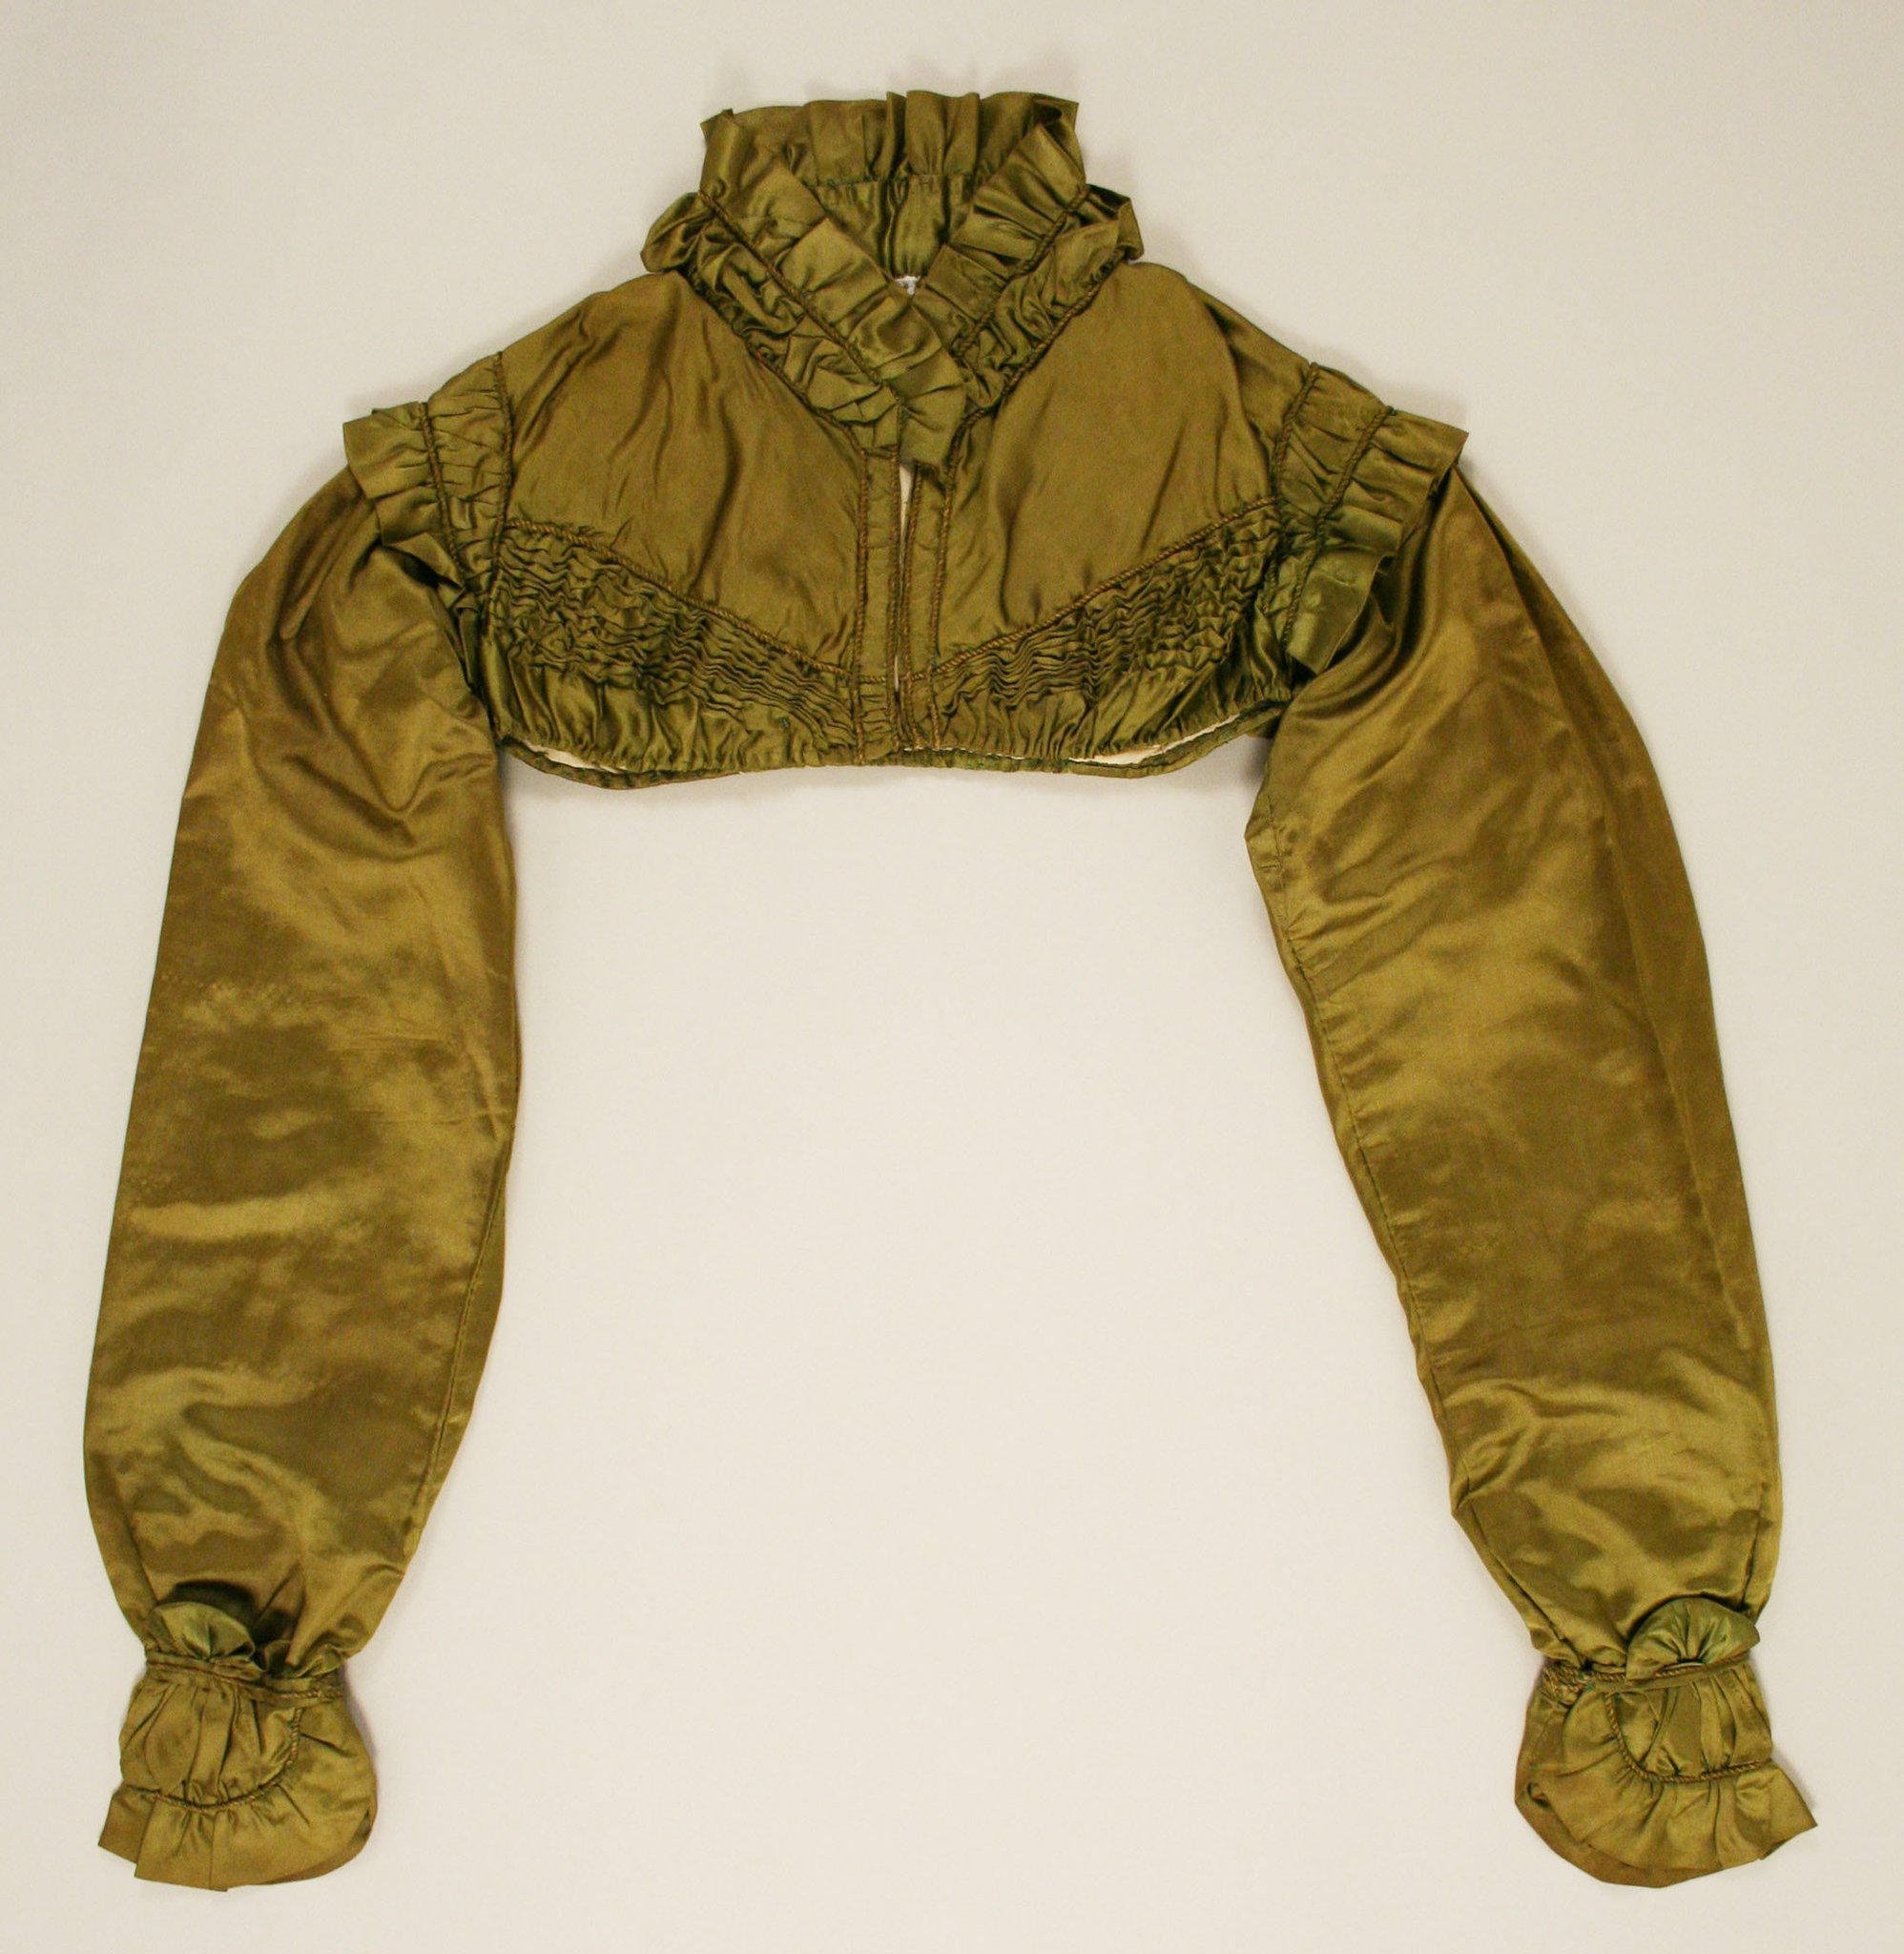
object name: spencer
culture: british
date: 1801-1833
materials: cotton, silk